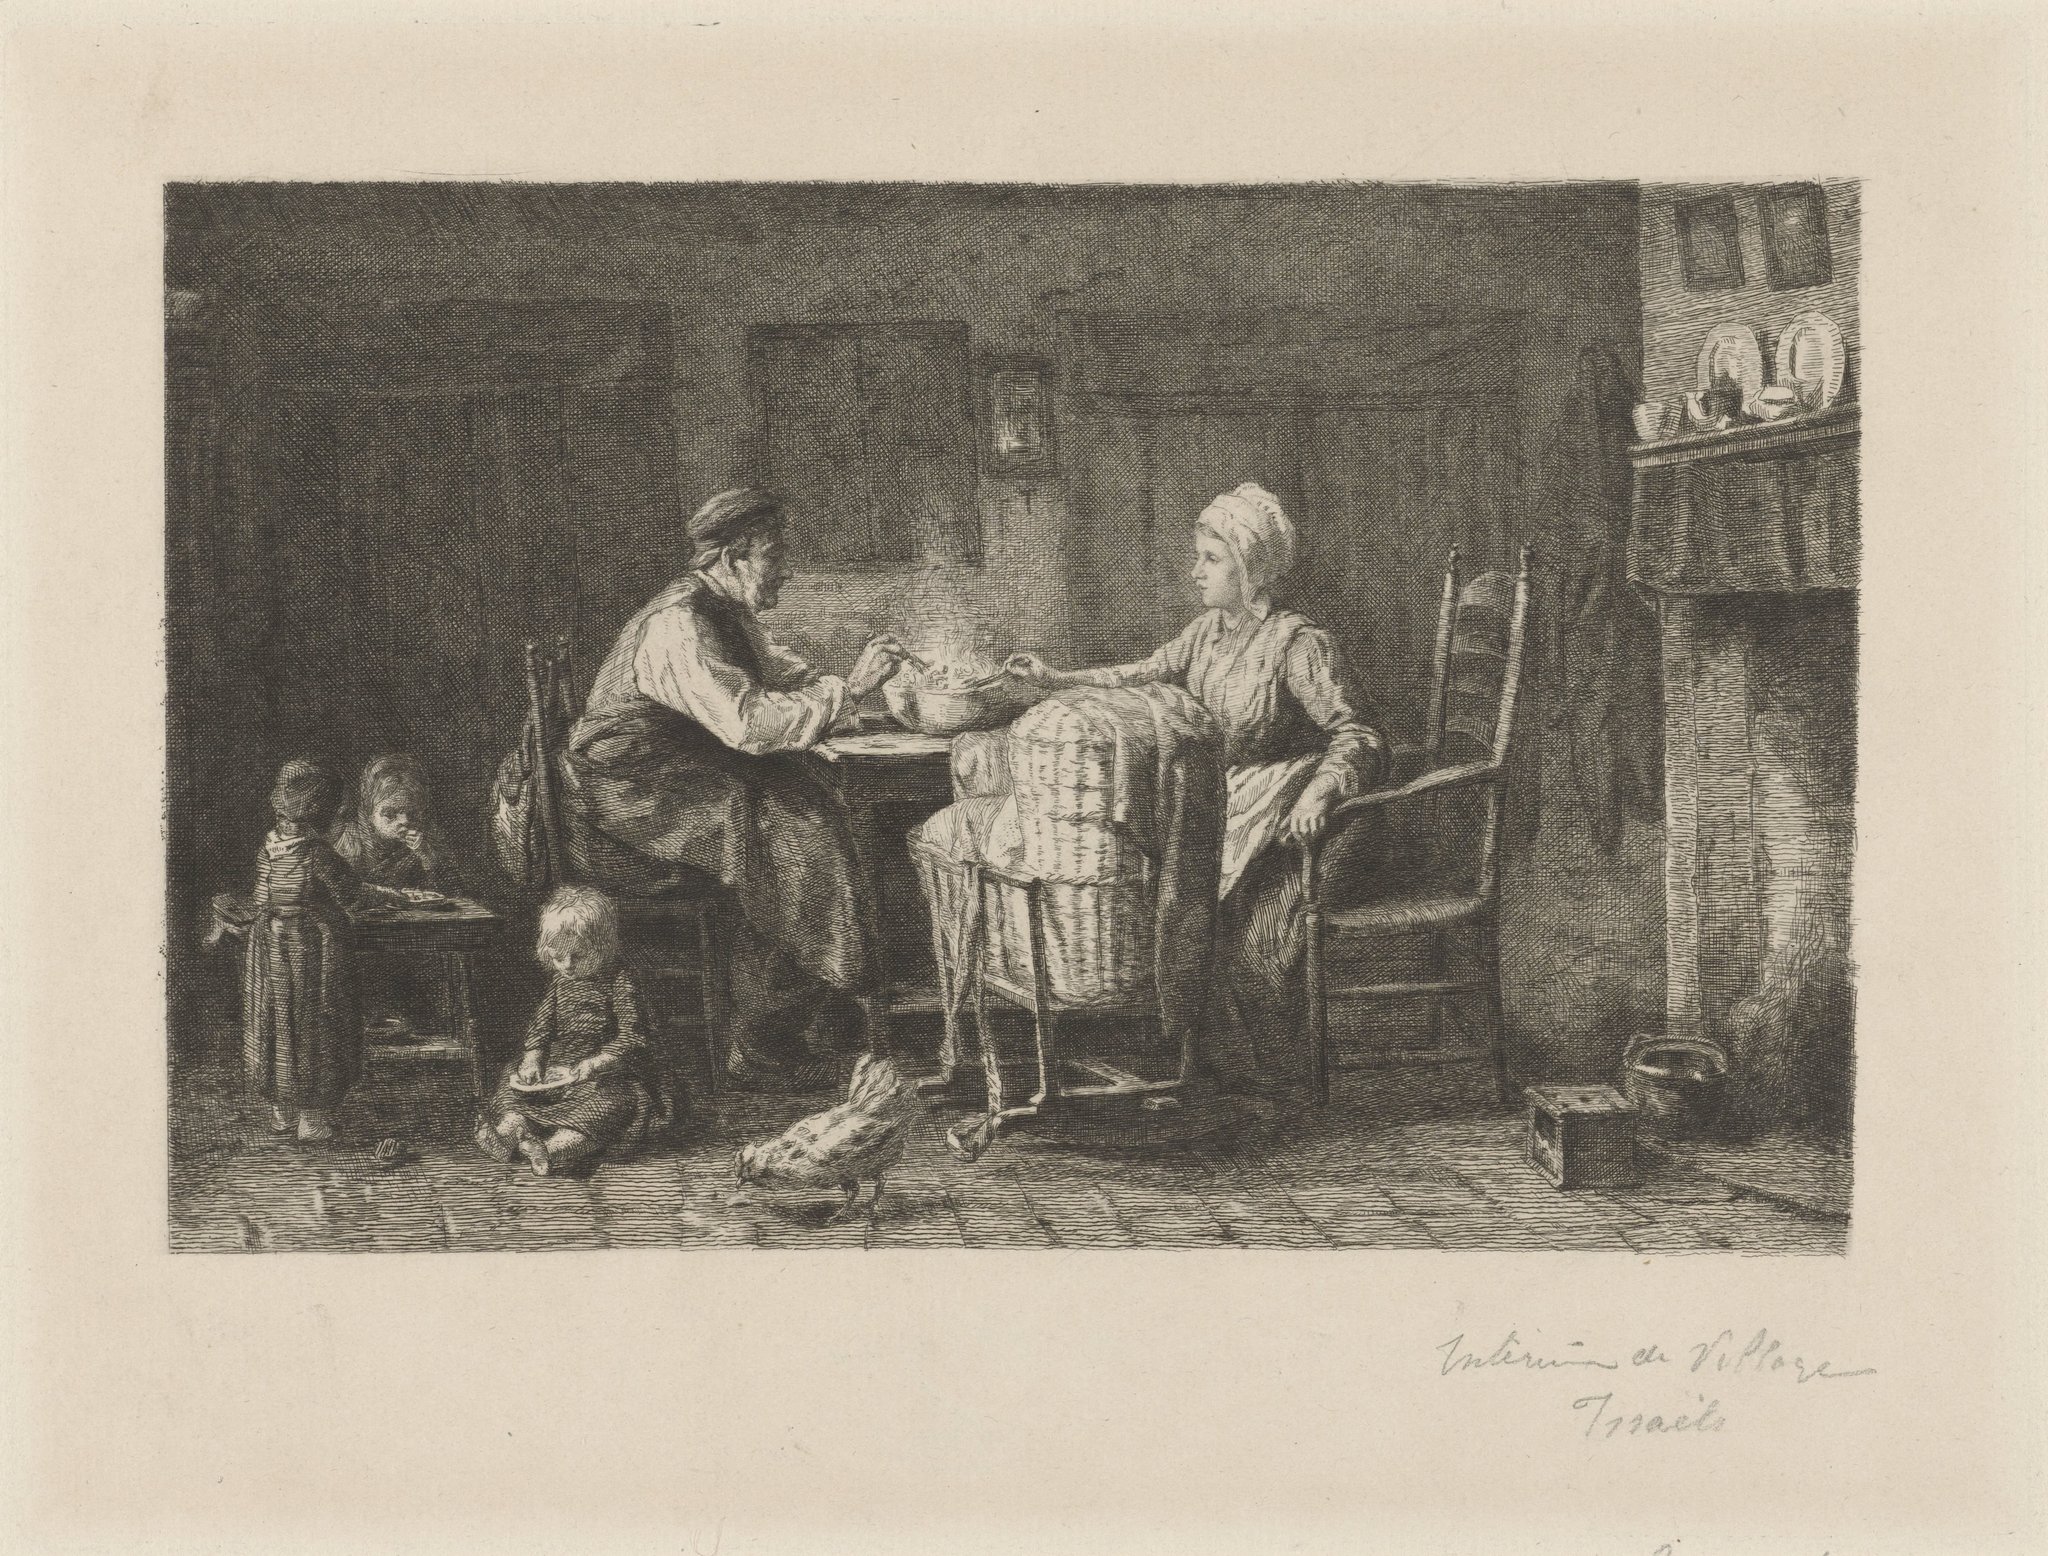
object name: print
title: Interieur met gezin aan de maaltijd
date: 1851-1893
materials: paper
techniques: etching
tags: interior of the house, cradle, crib, (family) meal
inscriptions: collector's mark: Lugt 2228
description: In een interieur zitten een man en een vrouw tegenover elkaar aan een tafel waarop een schotel staat. Een wieg staat tussen hen in. Links drie etende kinderen.